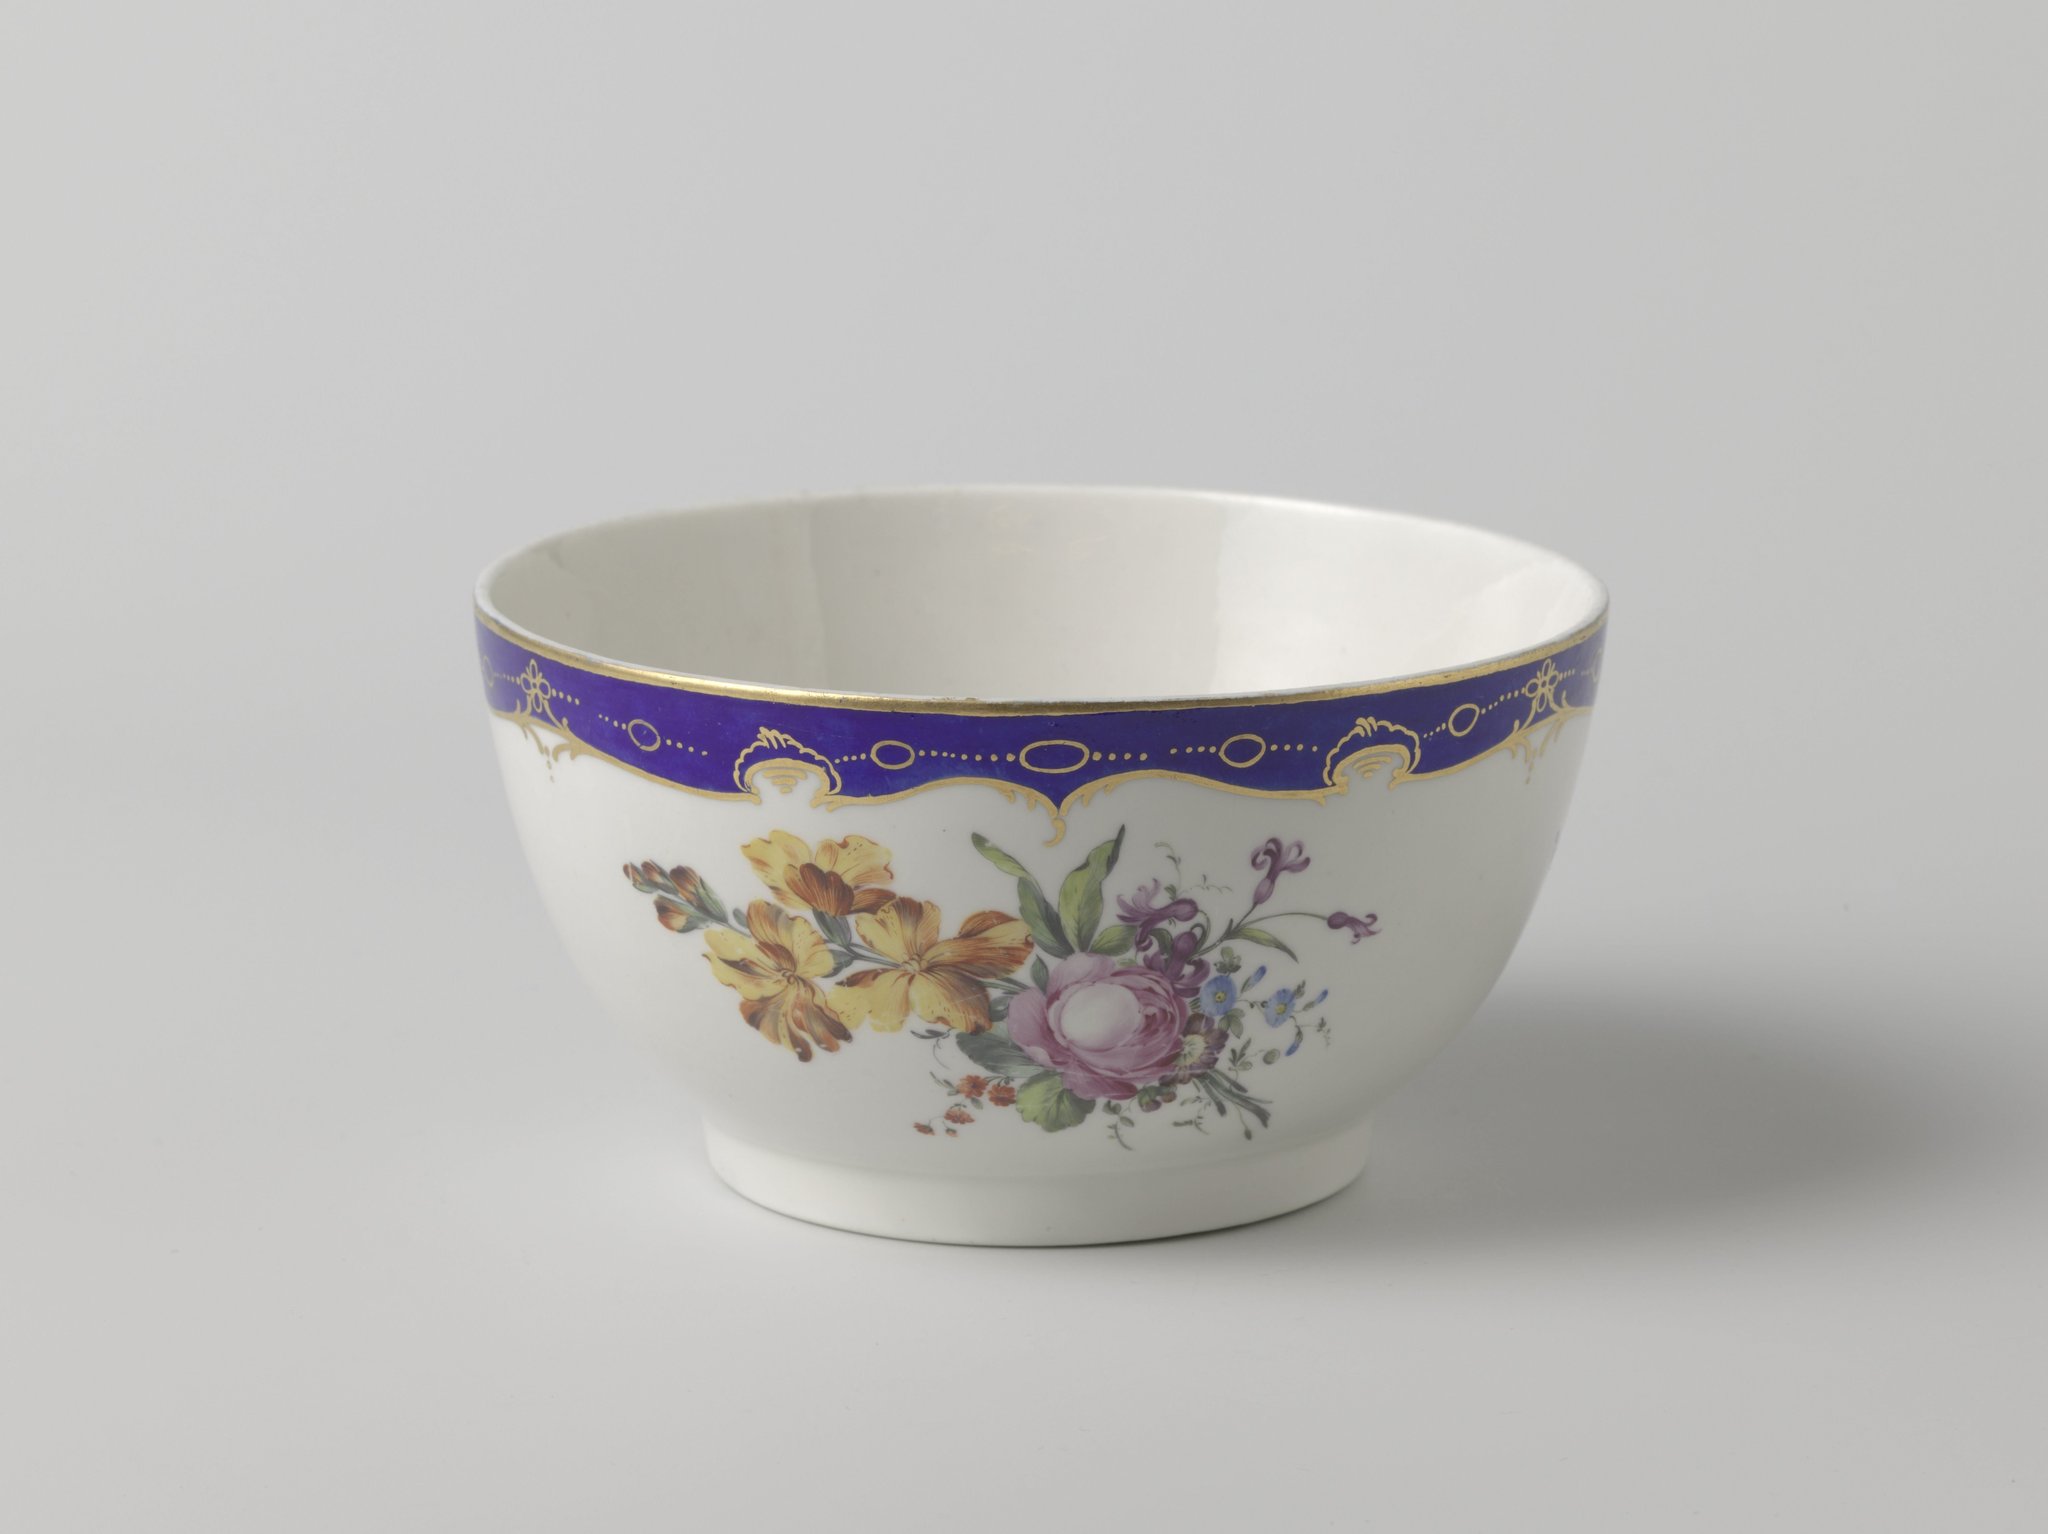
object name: slop bowl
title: Spoelkom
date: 1777-1790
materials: porcelain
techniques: painted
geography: the hague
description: Spoelkom, onderdeel van theeservies. Op de rand een blauwe band met rocaille ornament. Het hoofdmotief bestaat uit een bloemboeket omgeven door strooibloemen. Gemerkt met een ooievaar in bovenglazuurblauw. N.B. Doorniks zacht porselein beschilderd te Den Haag.